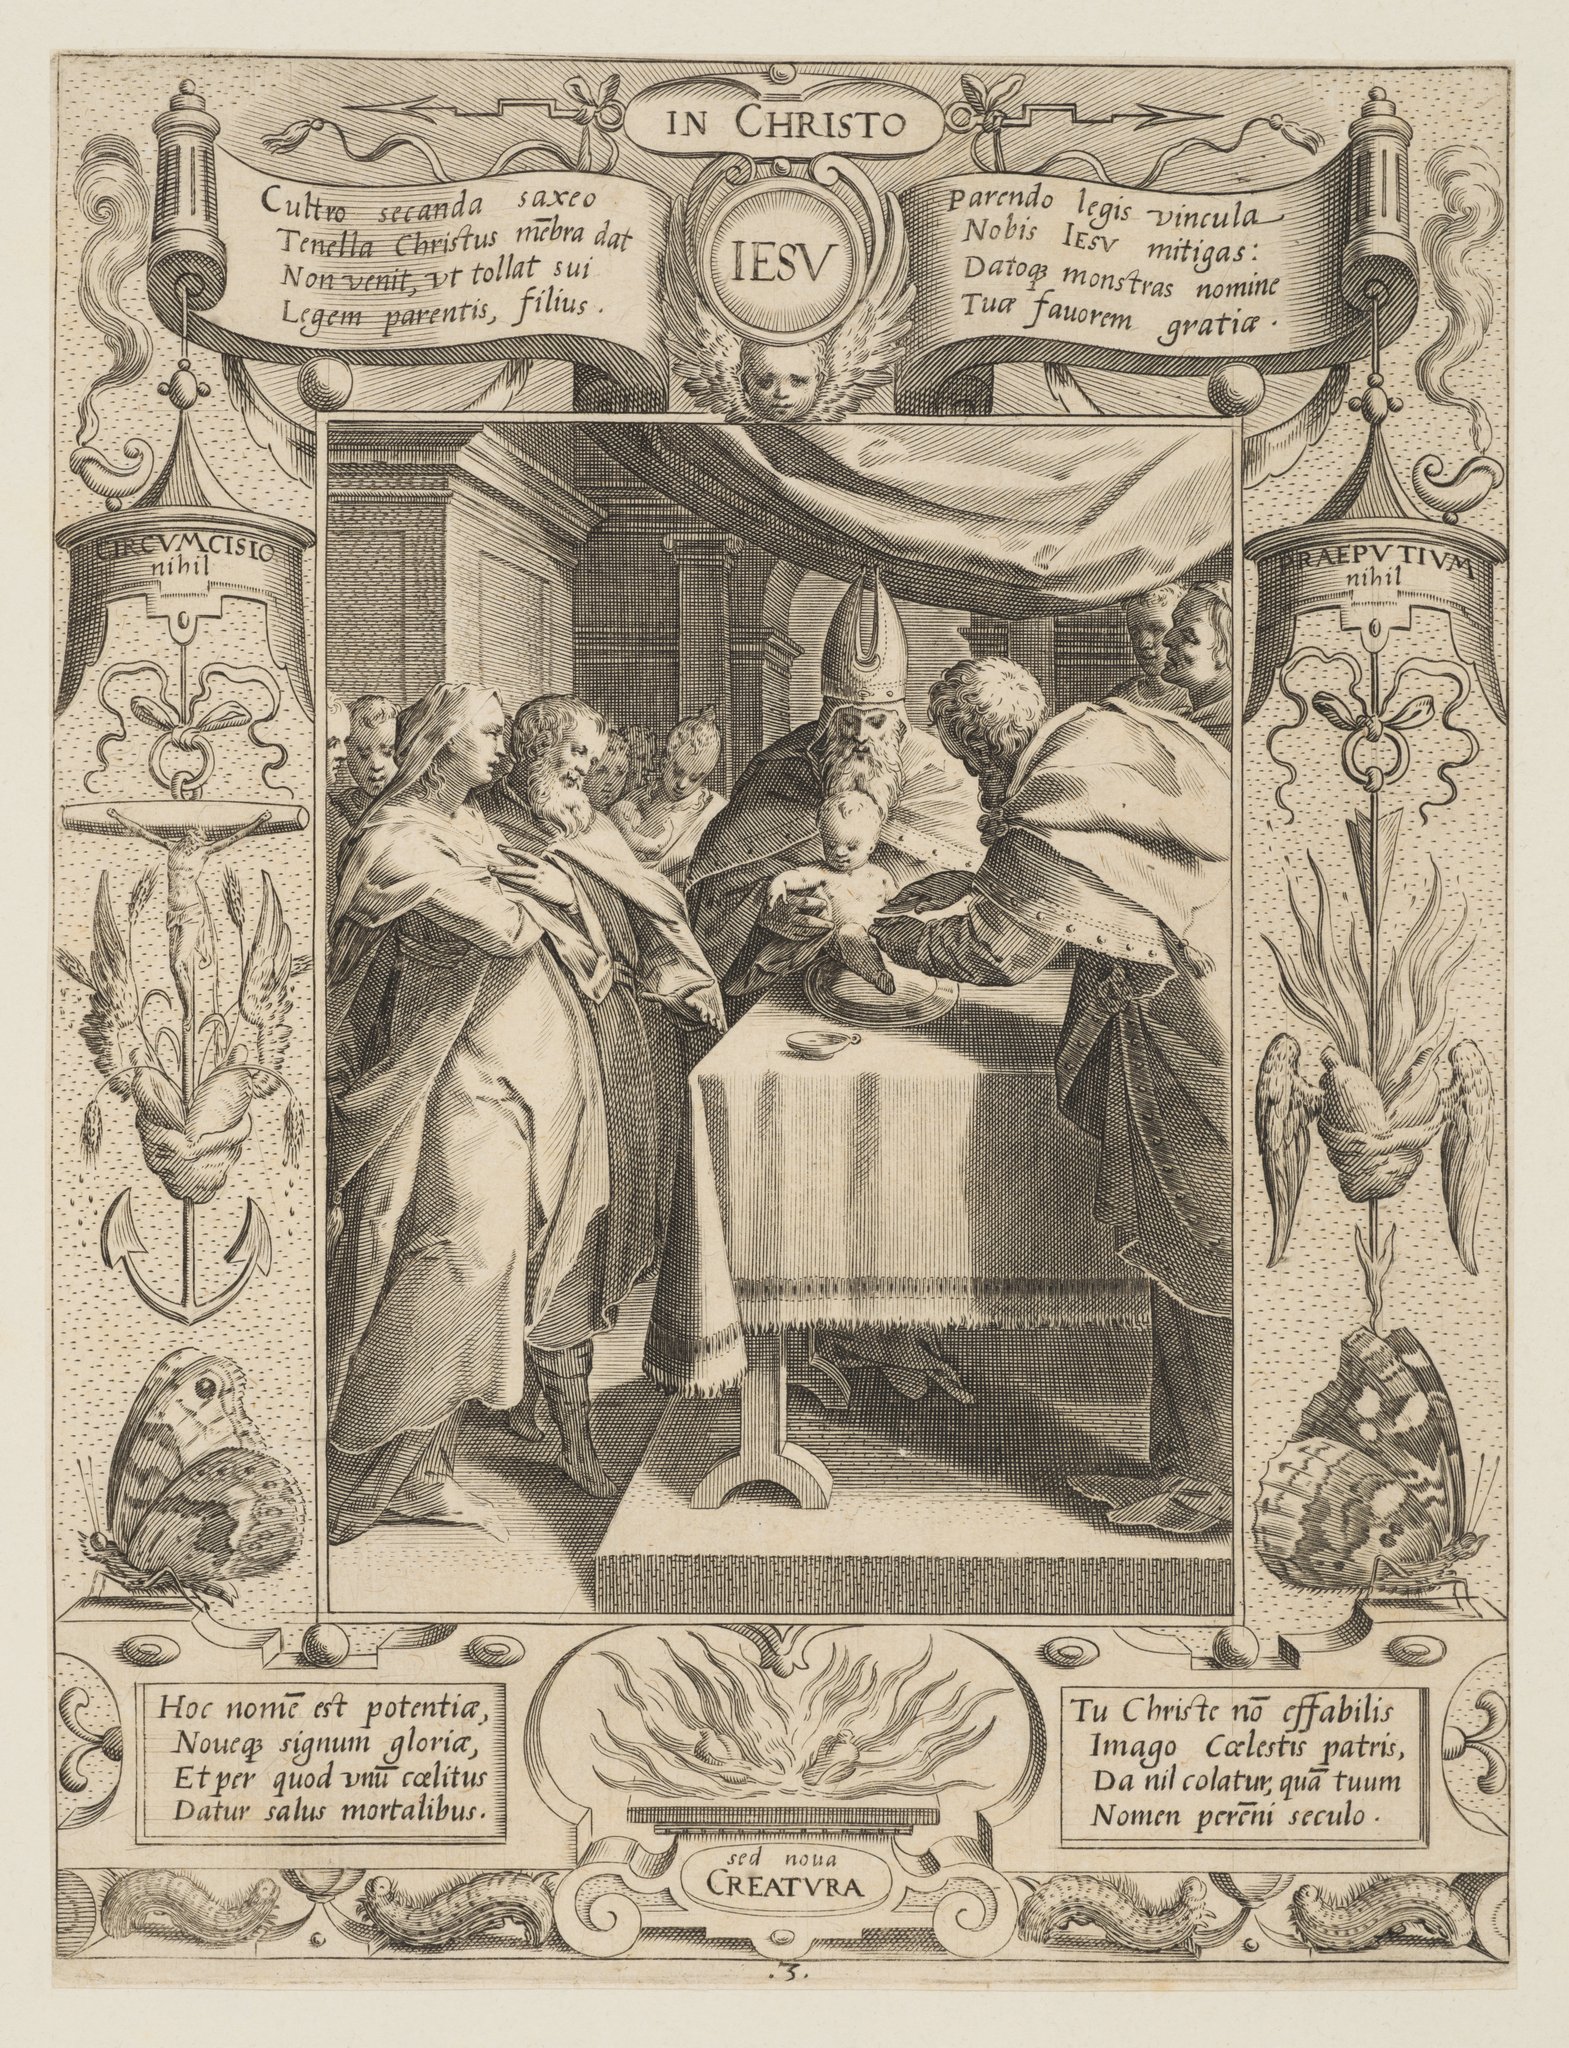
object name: print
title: Circumcision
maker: aegidius sadeler (ii)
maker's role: artist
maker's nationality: flemish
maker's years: 1568-1629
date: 1590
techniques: engraving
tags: christ,circumcision